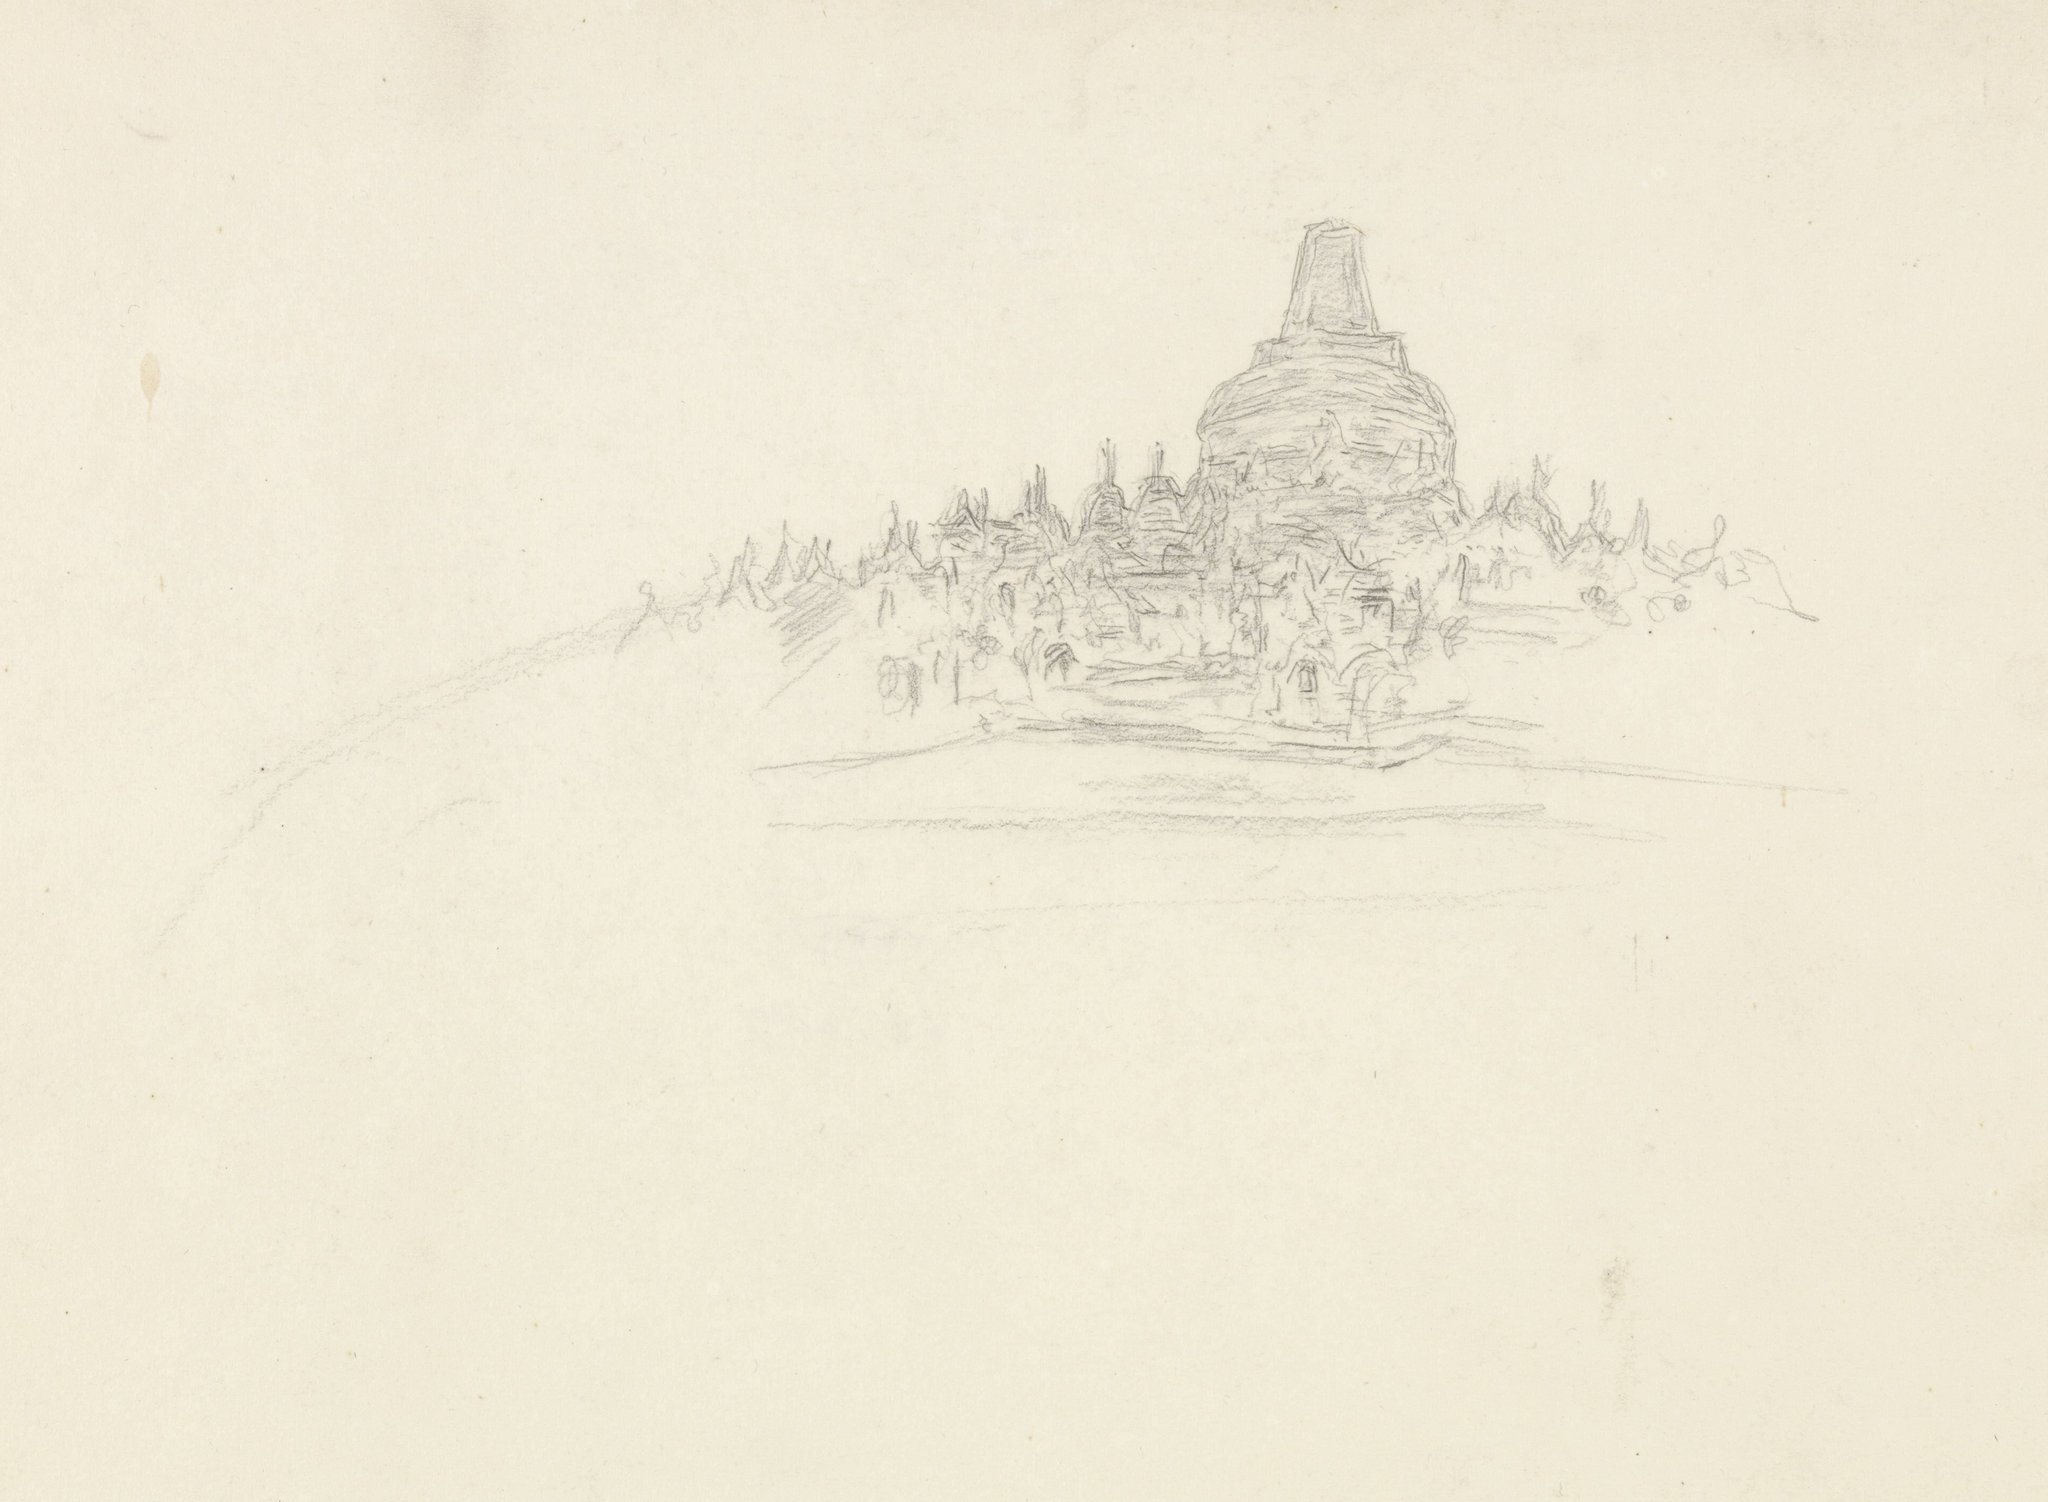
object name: drawing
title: Bovenste verdieping van de Borobúdur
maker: jan veth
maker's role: designer, draughtsman, painter, print maker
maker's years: 1864-1925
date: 1921-1922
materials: paper, pencil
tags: temple, shrine ~ hinduism, buddhism, jainism, java, dutch east indies, the